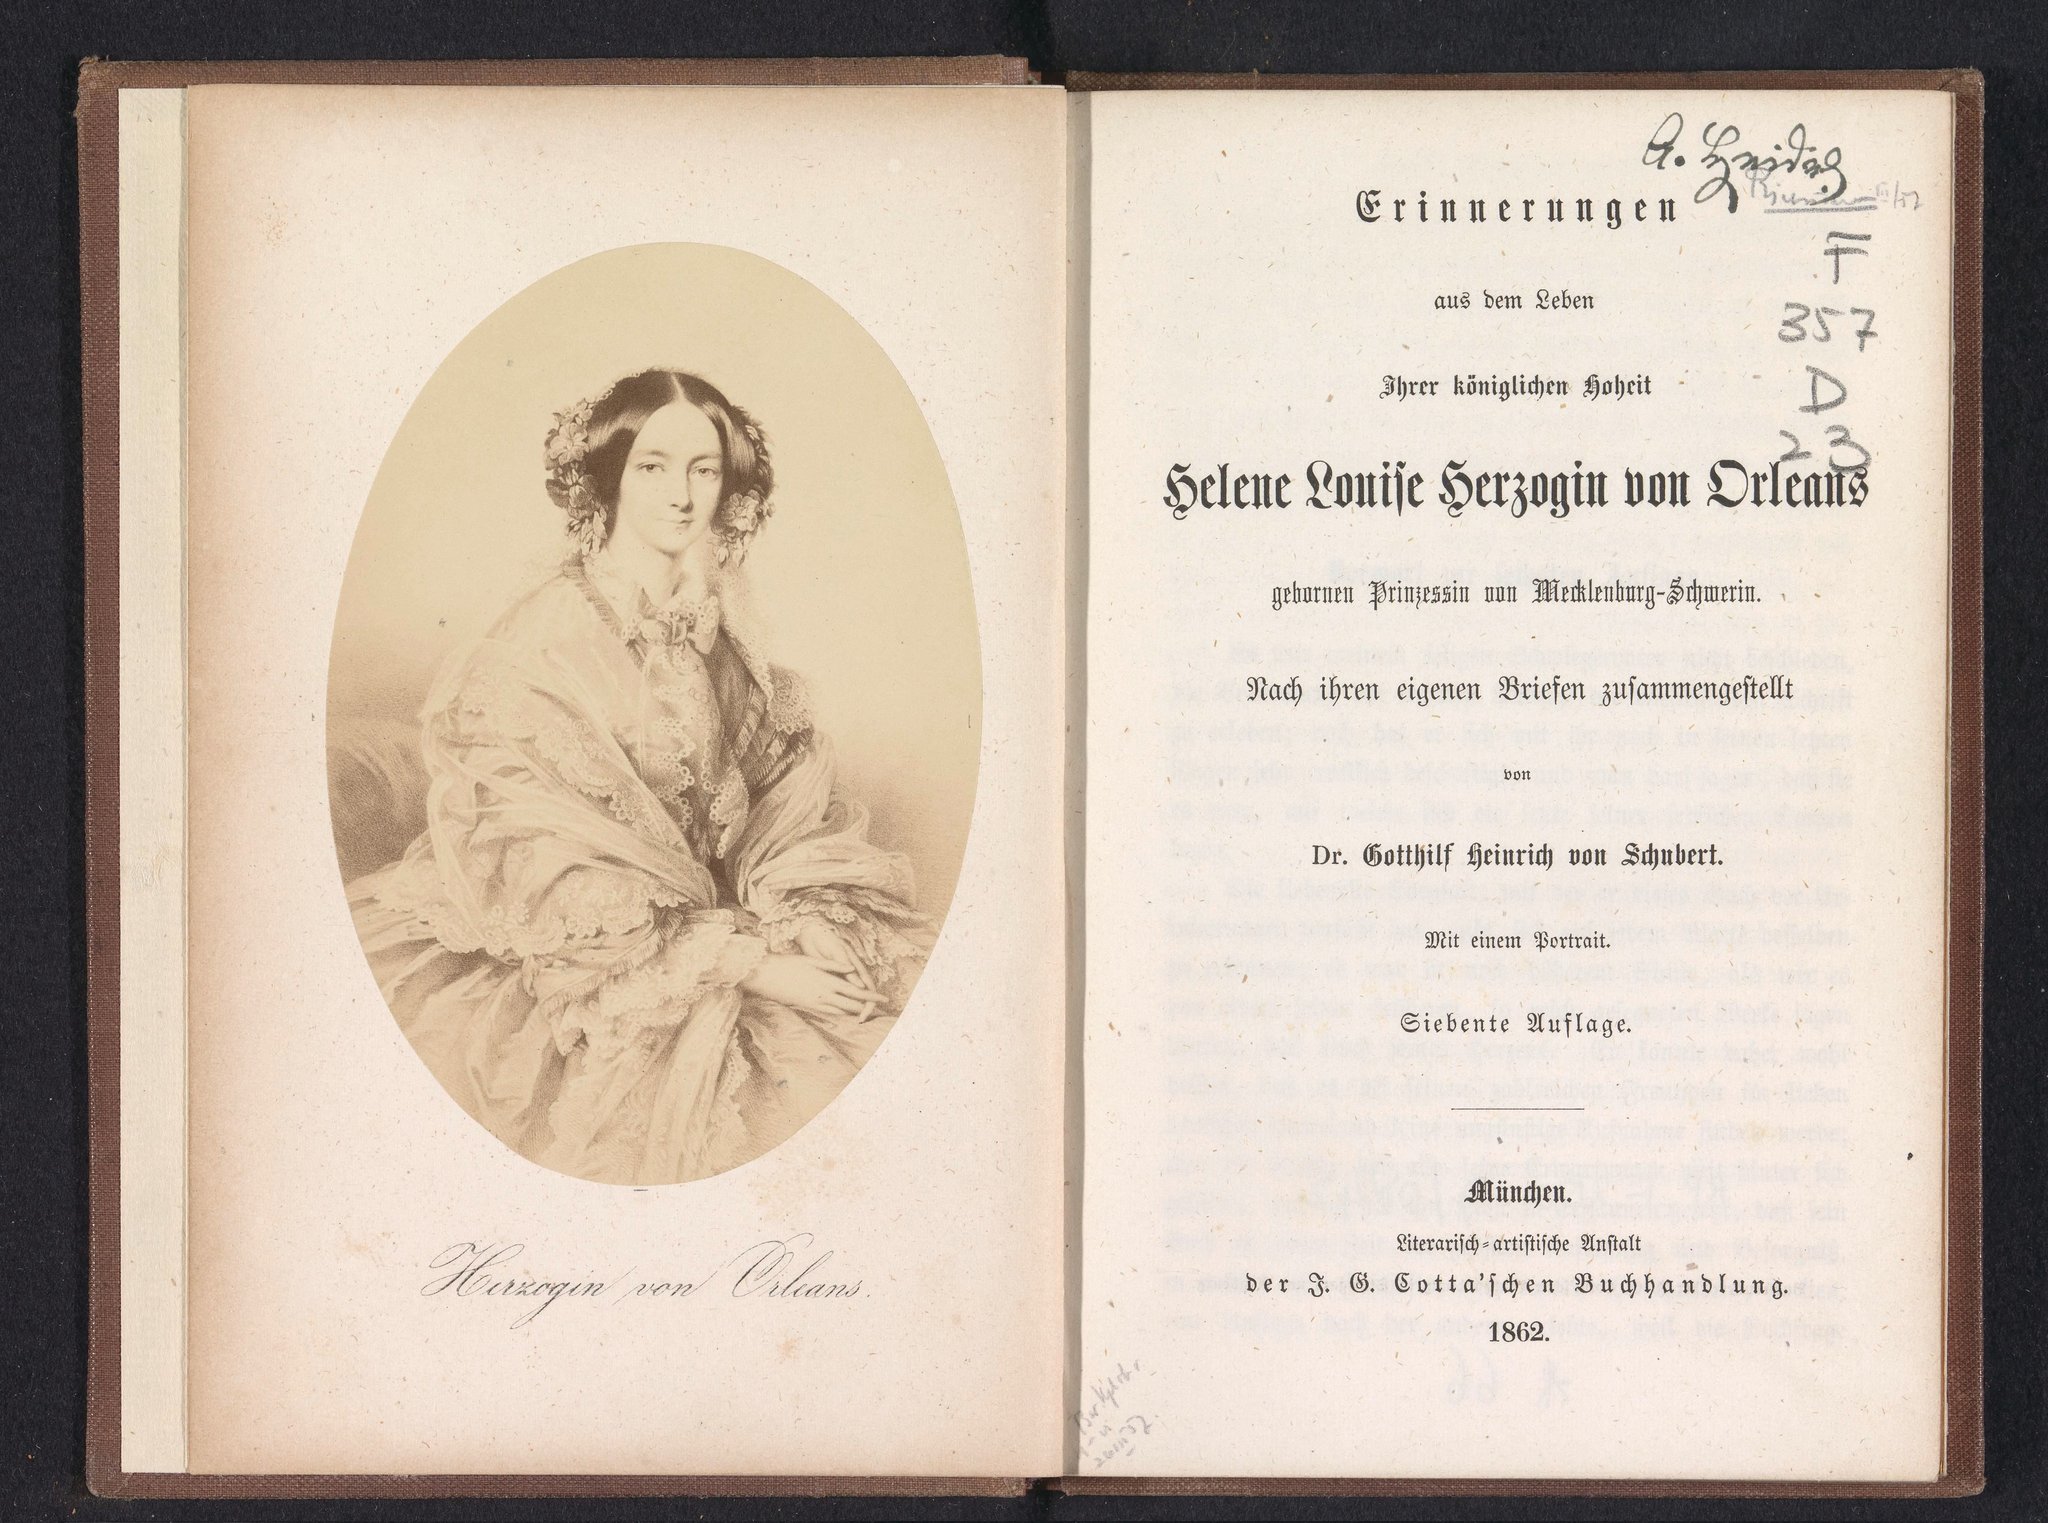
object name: book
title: Erinnerungen aus dem Leben Ihrer königlichen Hoheit Helene Louise Herzogin von Orleans gebornen Prinsessin von Mecklenburg-Schwerin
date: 1862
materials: cardboard, linen, paper, photographic support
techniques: albumen print, printing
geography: munich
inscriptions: name: ‘A. [..]as’